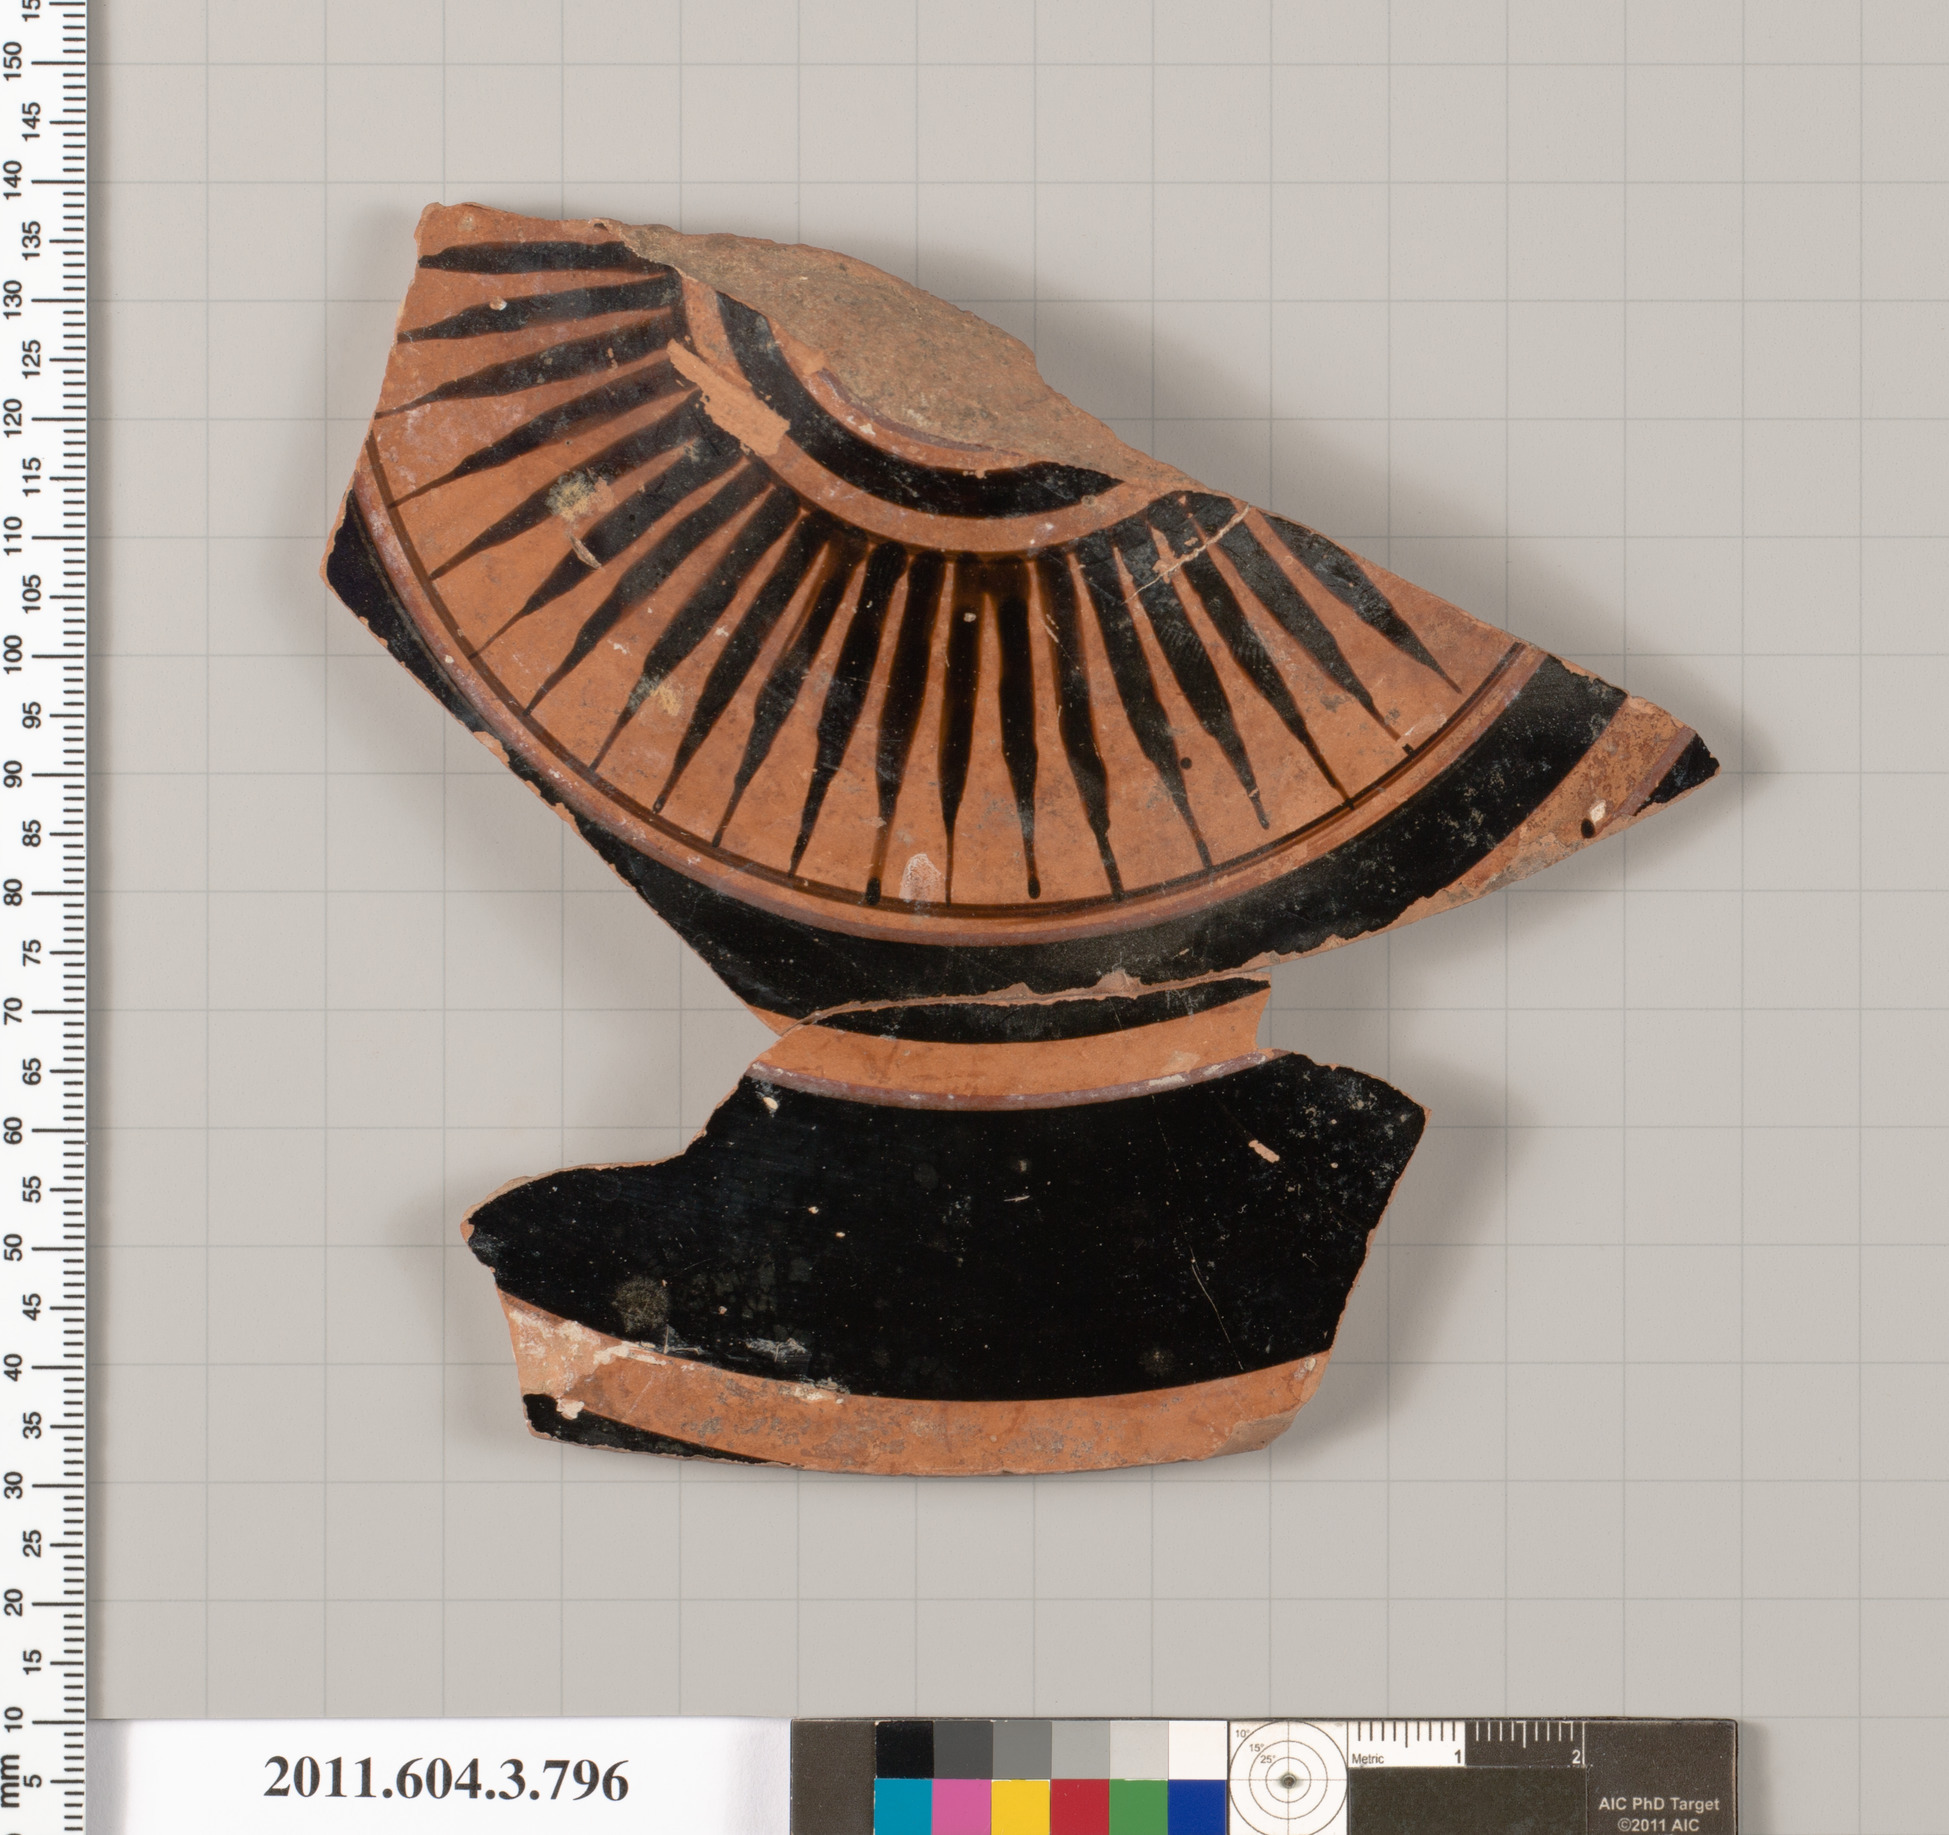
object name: lid fragment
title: Terracotta fragment of a lid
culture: greek, attic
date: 600-501 BCE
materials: terracotta